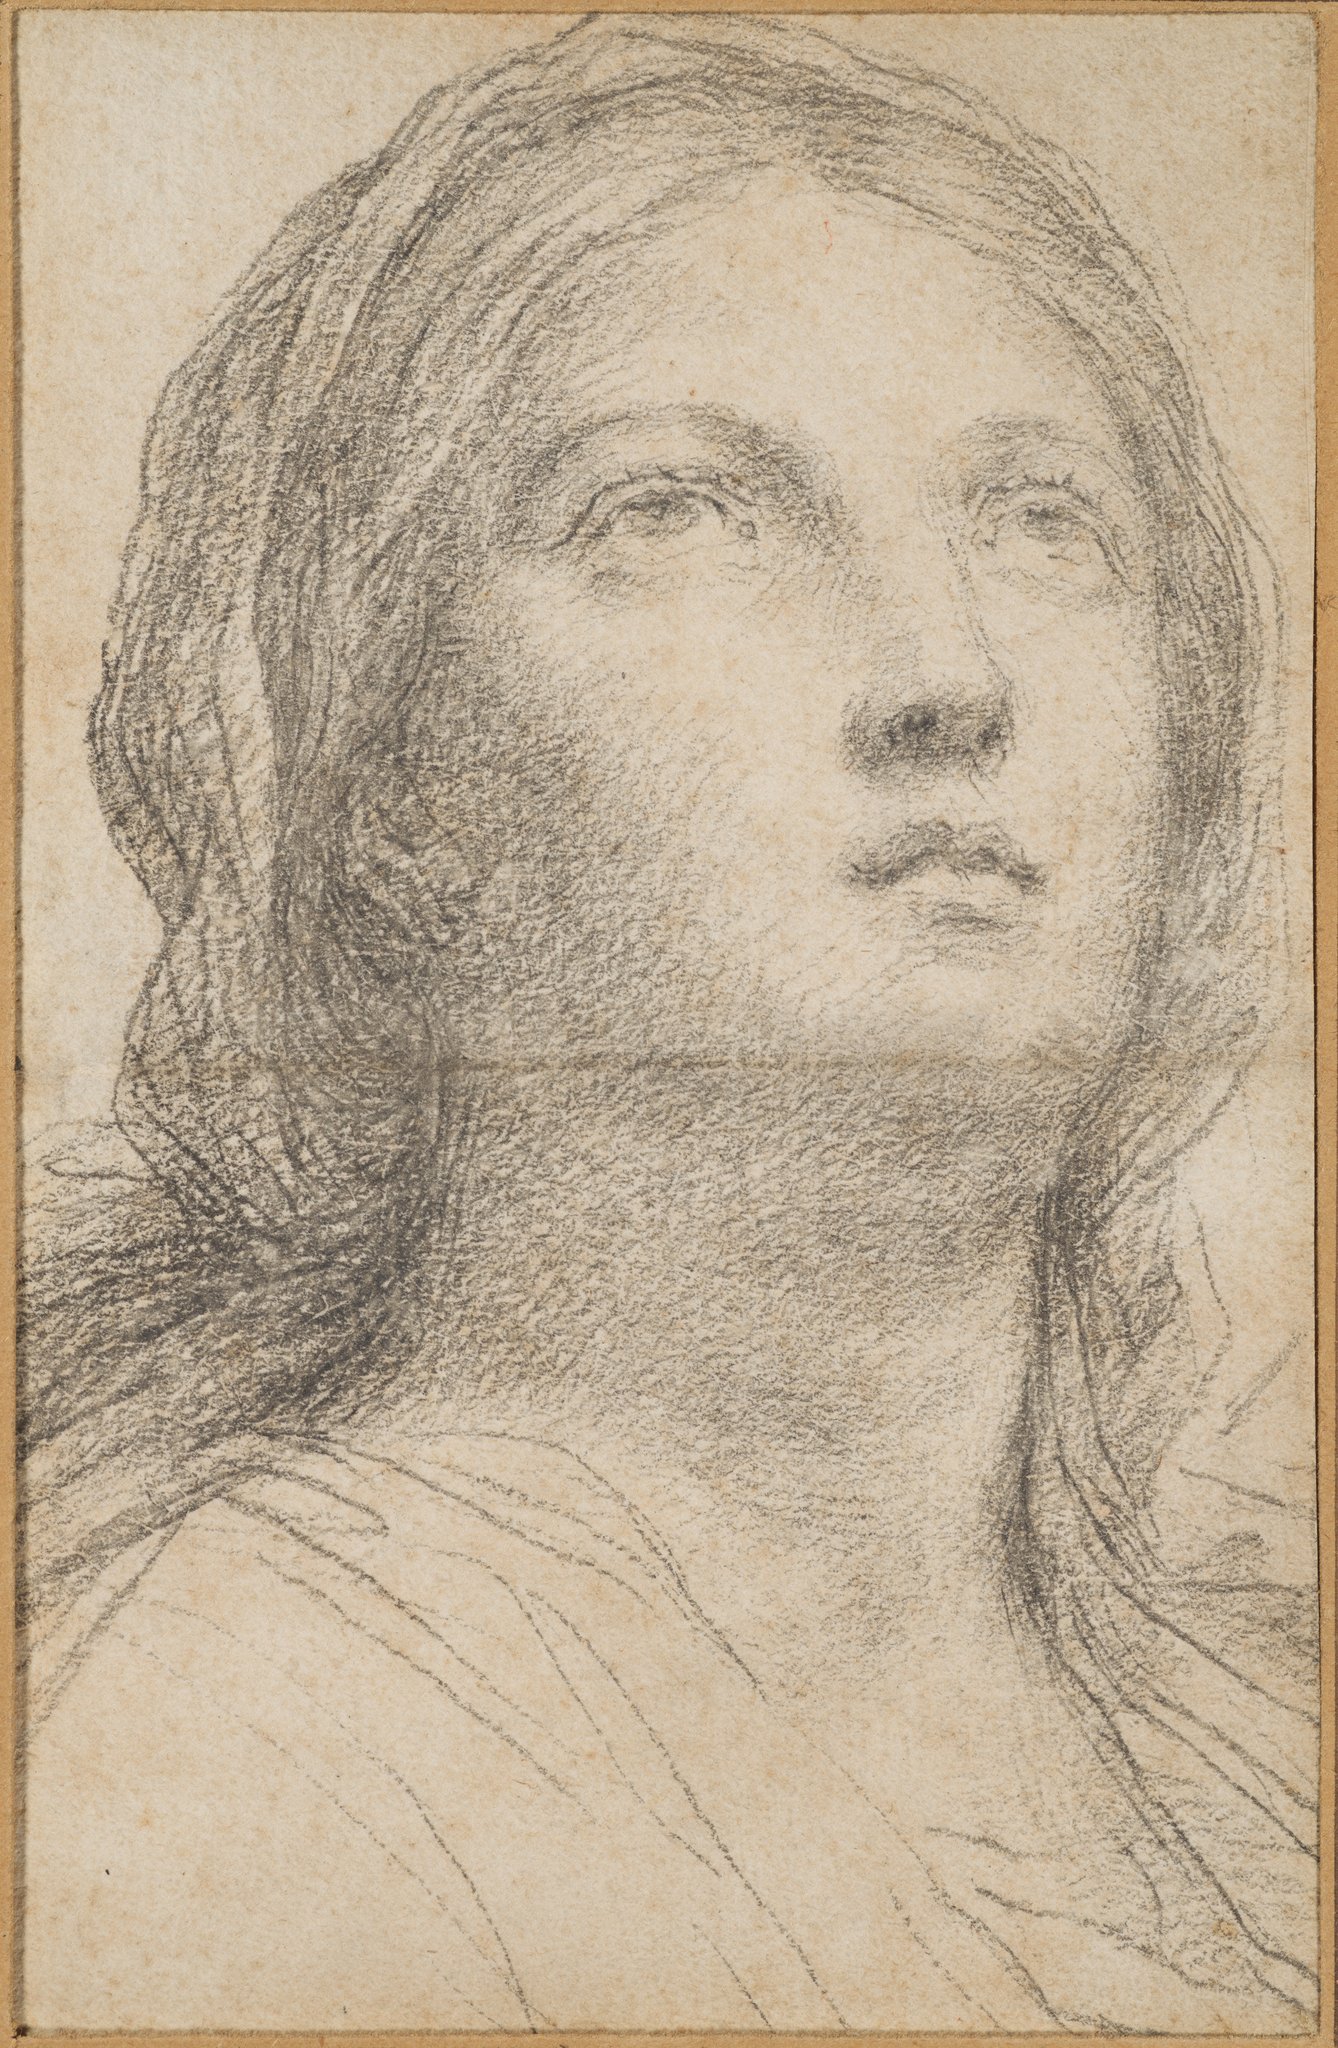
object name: drawing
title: A pious woman, in bust-length, three-quarter view, with head raised to the upper right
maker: anonymous, italian, late 17th to early 18th century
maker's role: artist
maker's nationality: italian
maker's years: 1650-1750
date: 1667-1733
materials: chalk, paper